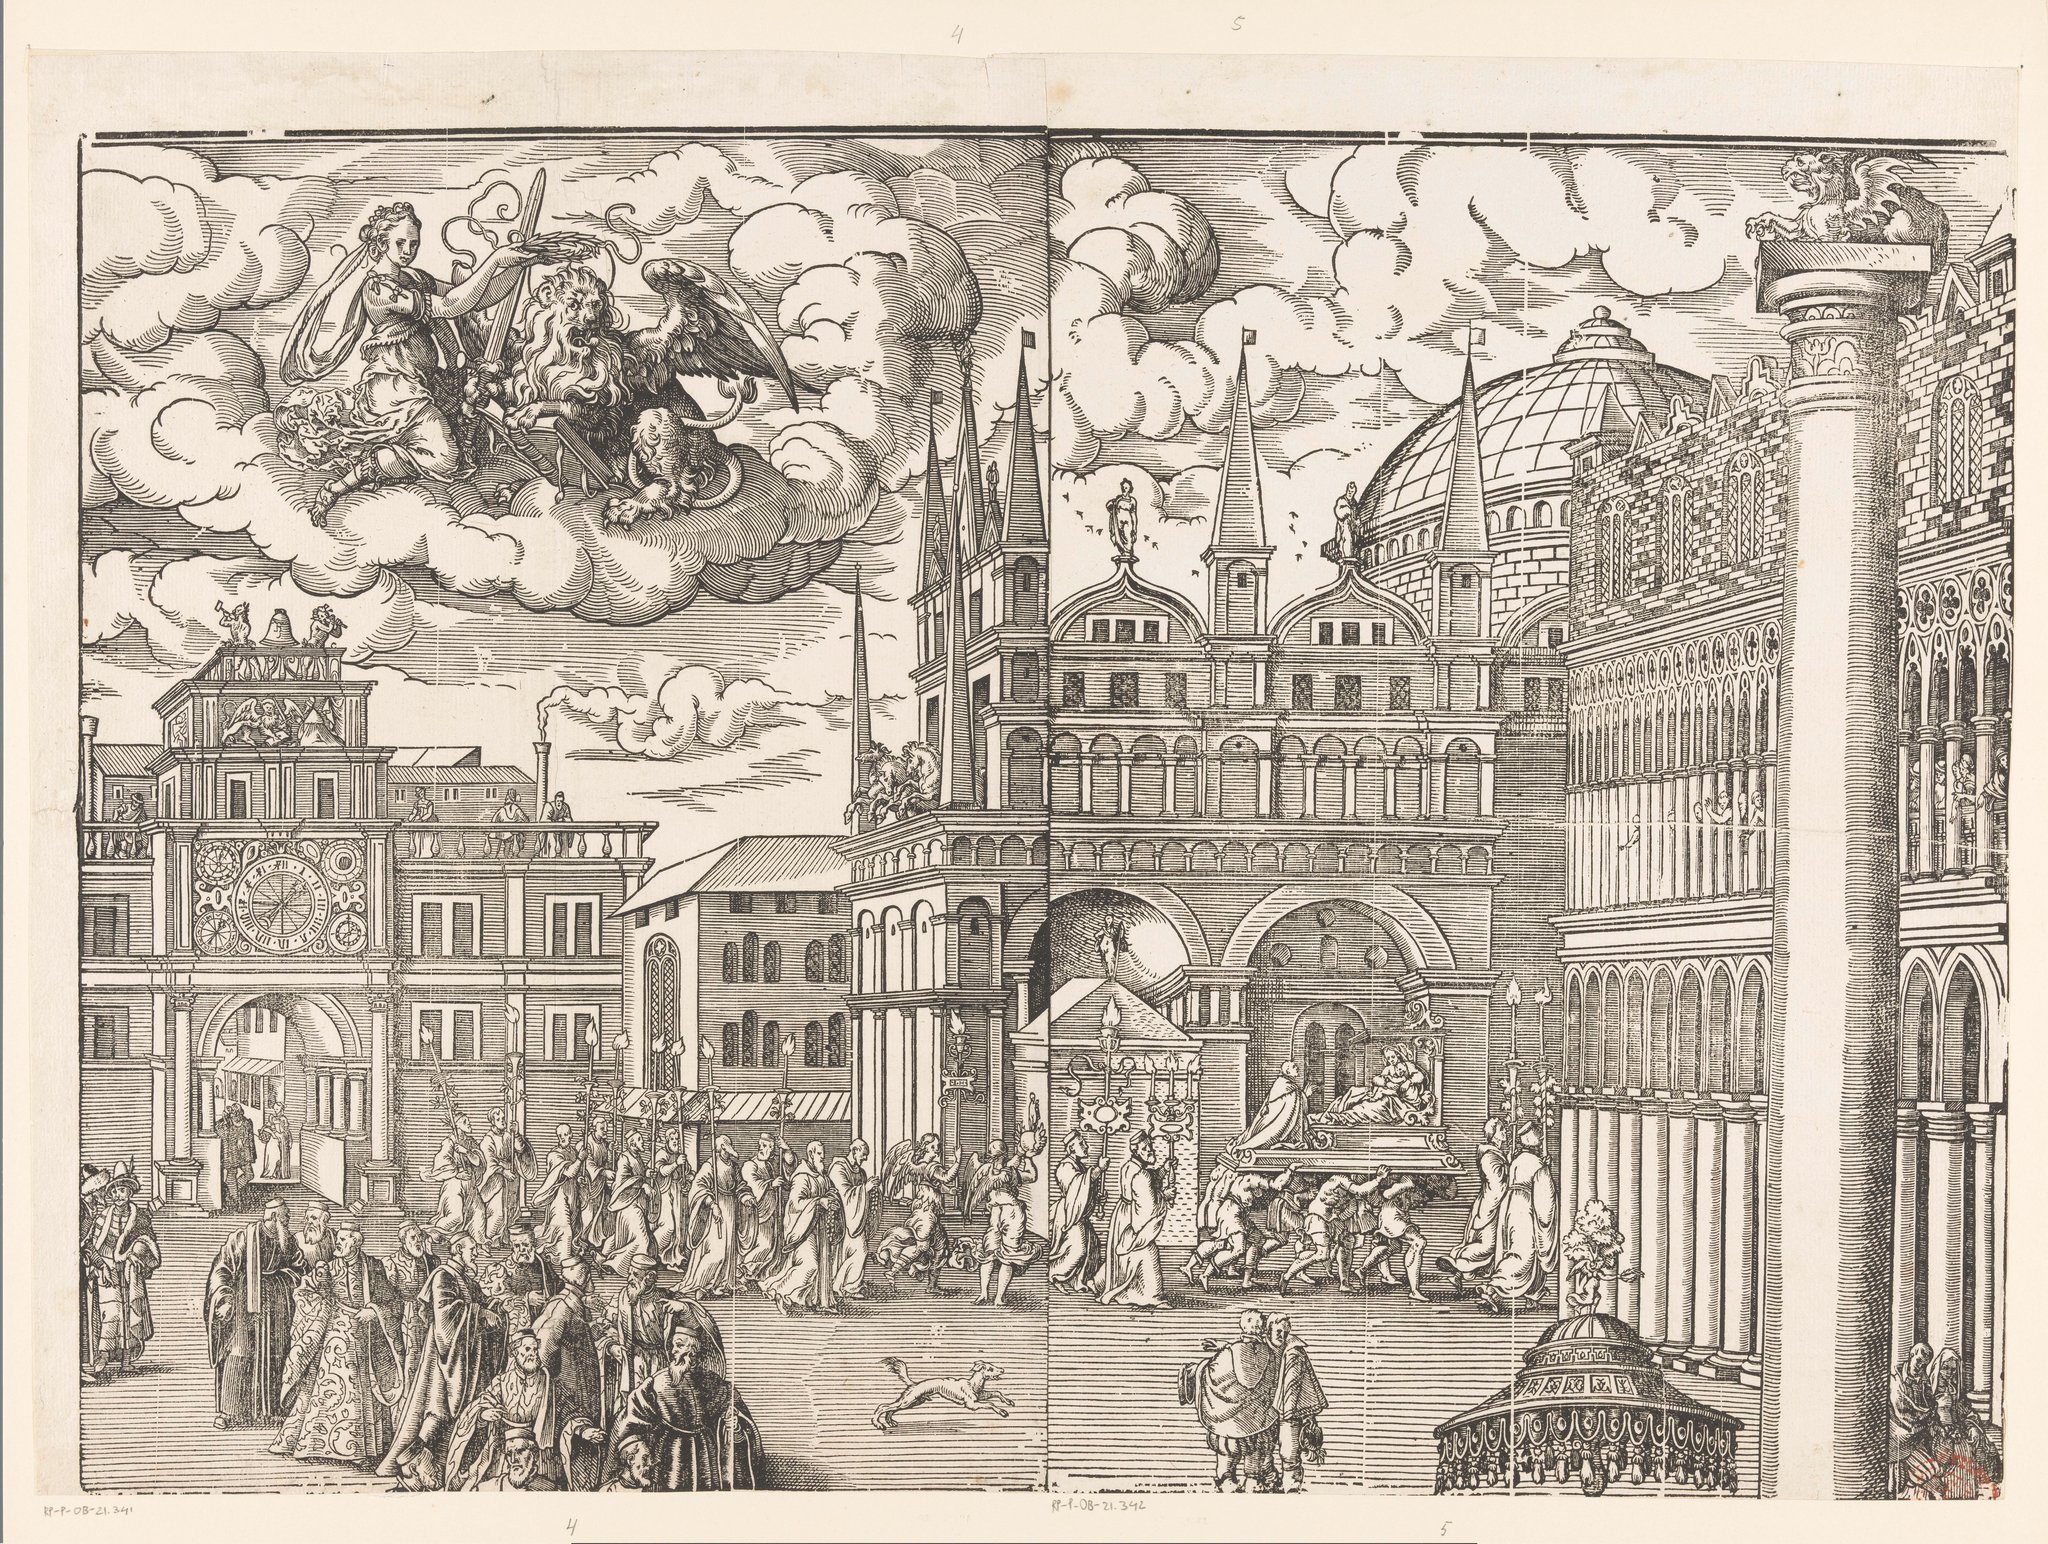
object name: print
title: Ankunfft Und herkommen der weitberümbten herrlichen Statt Venedig Sambt derselben gewaltigen Herrschafft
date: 1679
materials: paper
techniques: woodcut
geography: nuremberg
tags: city-view in general; 'veduta', lion (possibly with book) ~ symbol of st. mark, church (exterior), clock, procession ~ christian religion, gondola, venice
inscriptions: collector's mark: Lugt 240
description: Vierde gedeelte van een grote voorstelling van de Festa della Sensa. De voorstelling is gedrukt van veertien blokken, de titel van vijf blokken en het onderschrift bestaat uit vijf delen van elk drie kolommen Duits tekst. De veertien blokken die samen de voorstelling vormen zijn in de titels met de klok mee vanaf linksboven genummerd. In de collectie Rijksmuseum bevinden zich twee complete exemplaren inclusief titel en onderschrift. Omdat niet alle delen van de titel en het onderschrift op afzonderlijke bladen zijn gedrukt, is dit exemplaar niet virtueel samengevoegd omwille van een betere presentatie. Zie voor het andere exemplaar: RP-P-2017-6073.